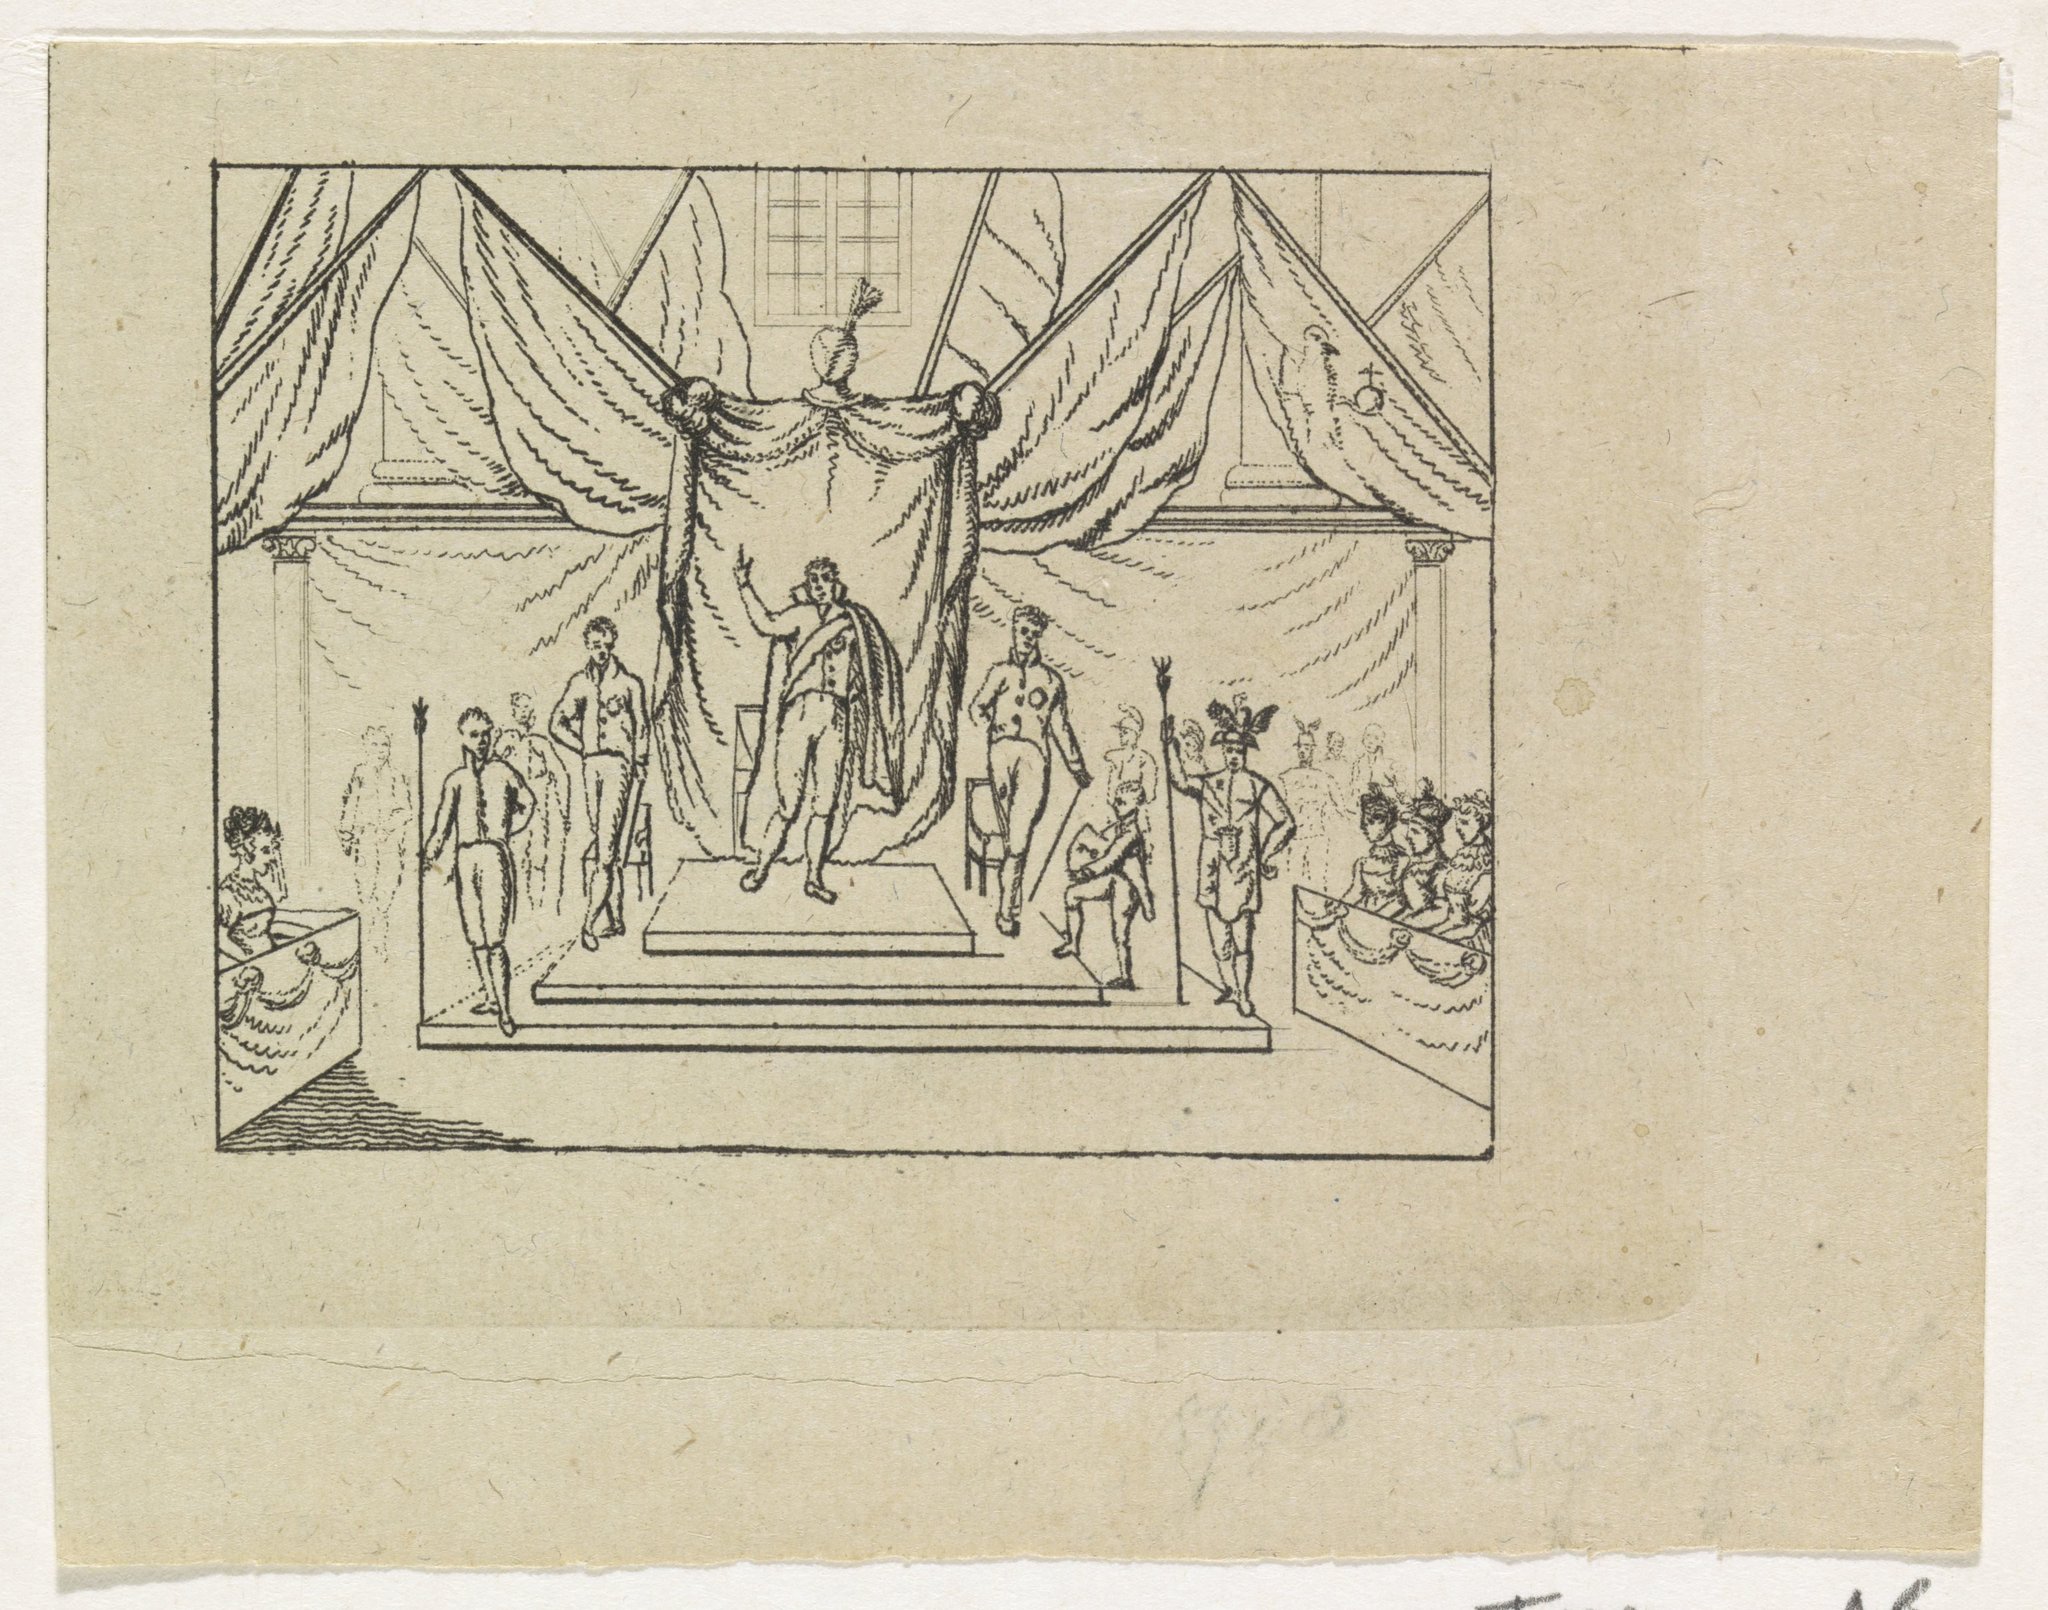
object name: print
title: Inhuldiging van Willem Frederik, prins van Oranje als souverein vorst, 1814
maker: Anonymous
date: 1814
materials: paper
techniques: etching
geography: netherlands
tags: the hague, berlin, william i of the netherlands, ceremonial celebration of installation of a ruler, new ruler taking the oath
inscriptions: collector's mark: Lugt 2228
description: Prins Willem Frederik ingehuldigd als soeverein vorst in de Nieuwe Kerk te Amsterdam op 30 maart 1814. De vorst legt staande tussen zijn twee zoons de eed af op de grondwet.